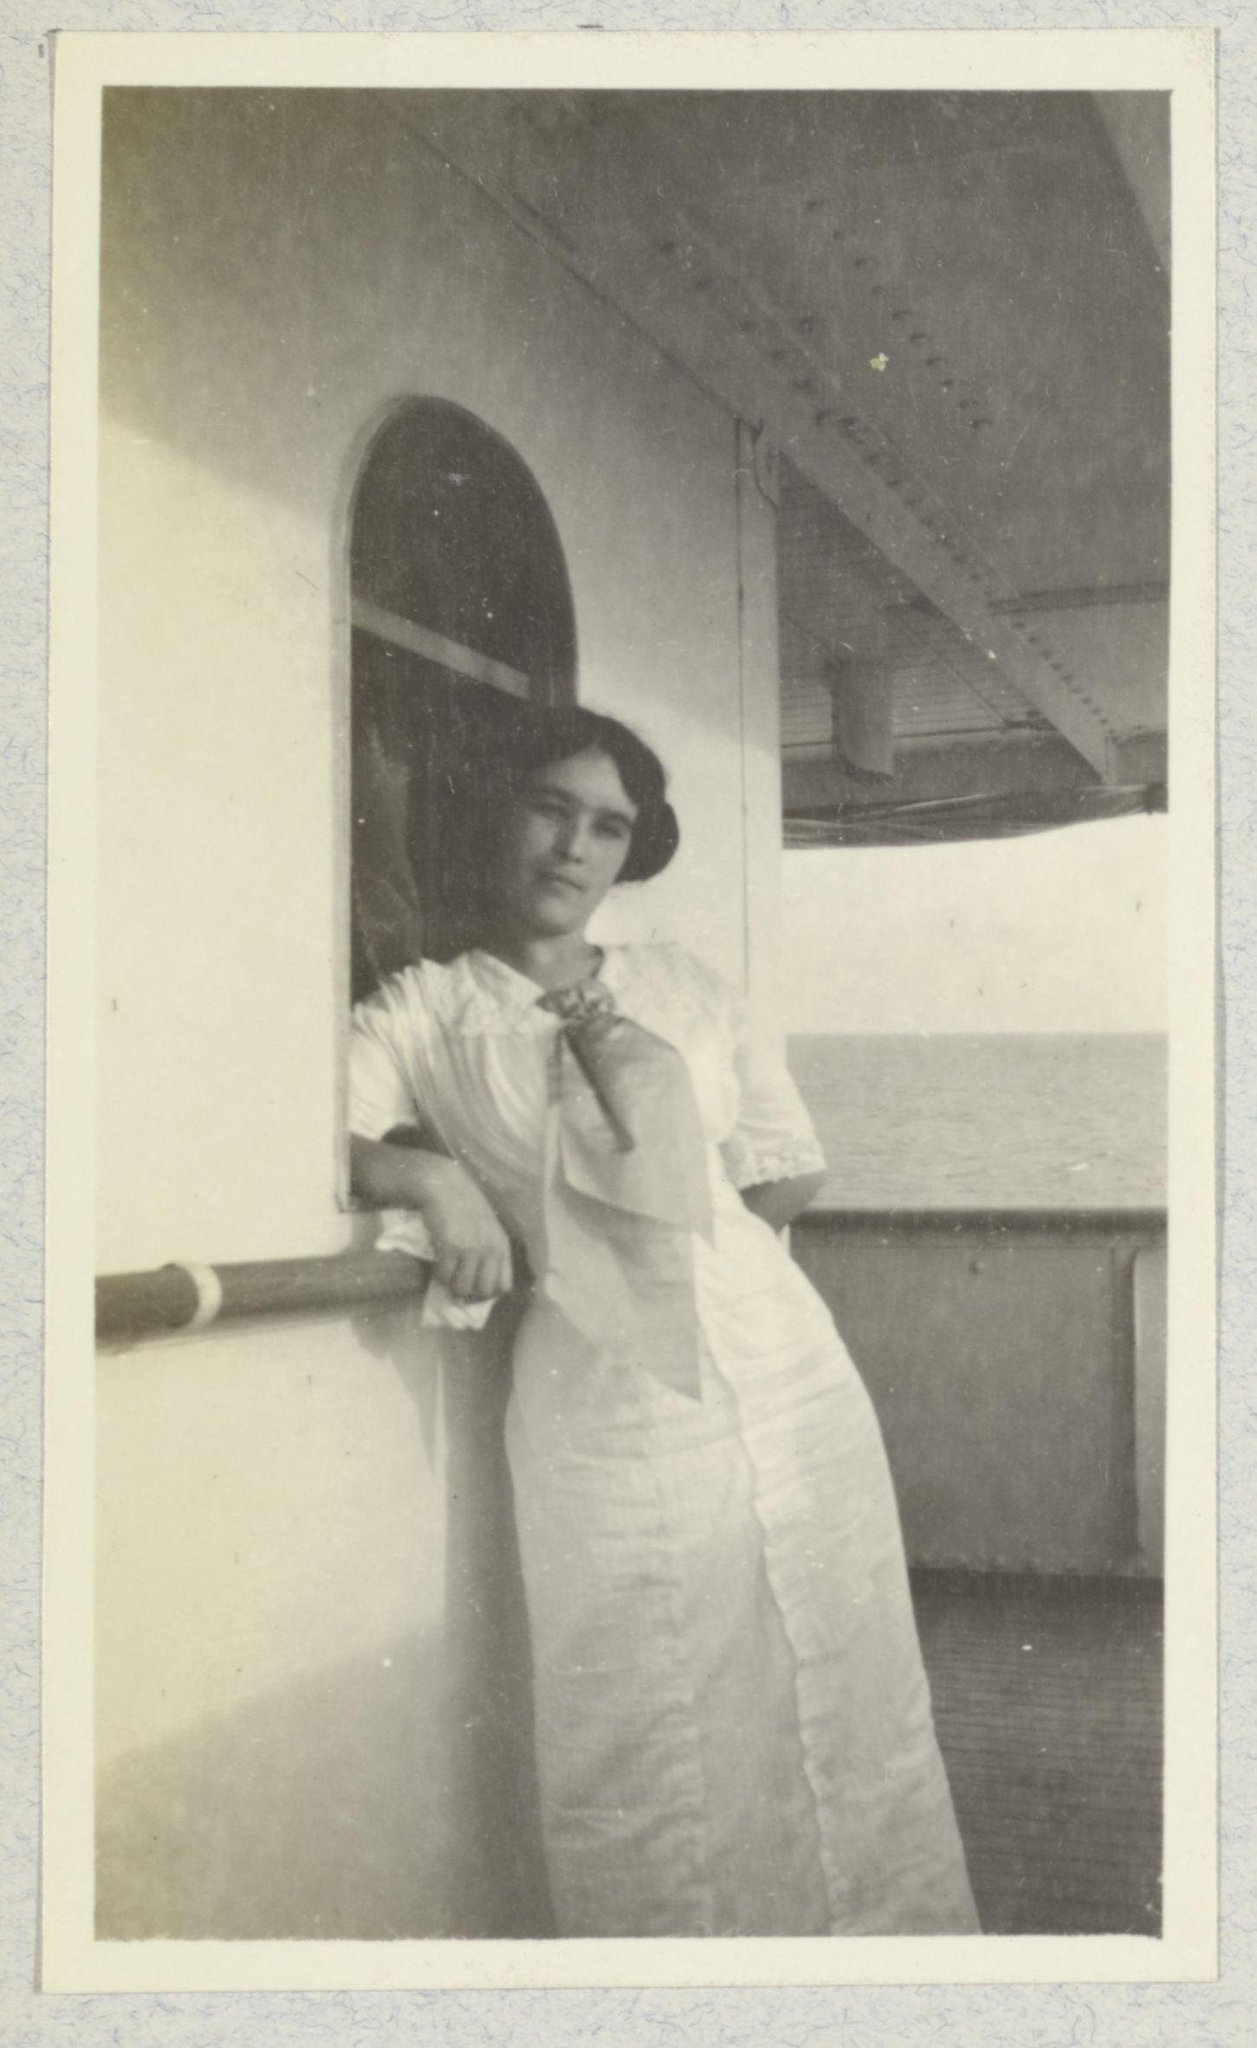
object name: photograph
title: Celia Gargollo, aan dek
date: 1908-1912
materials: photographic support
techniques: photography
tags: costa rica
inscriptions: date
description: Portret van Celia Gargollo, aan dek van het schip de S.S. Heredia, op zee in de omgeving van San José in Costa Rica, augustus 1912. Onderdeel van het fotoalbum van de familie Boom-Gonggrijp in Suriname en Curaçao.